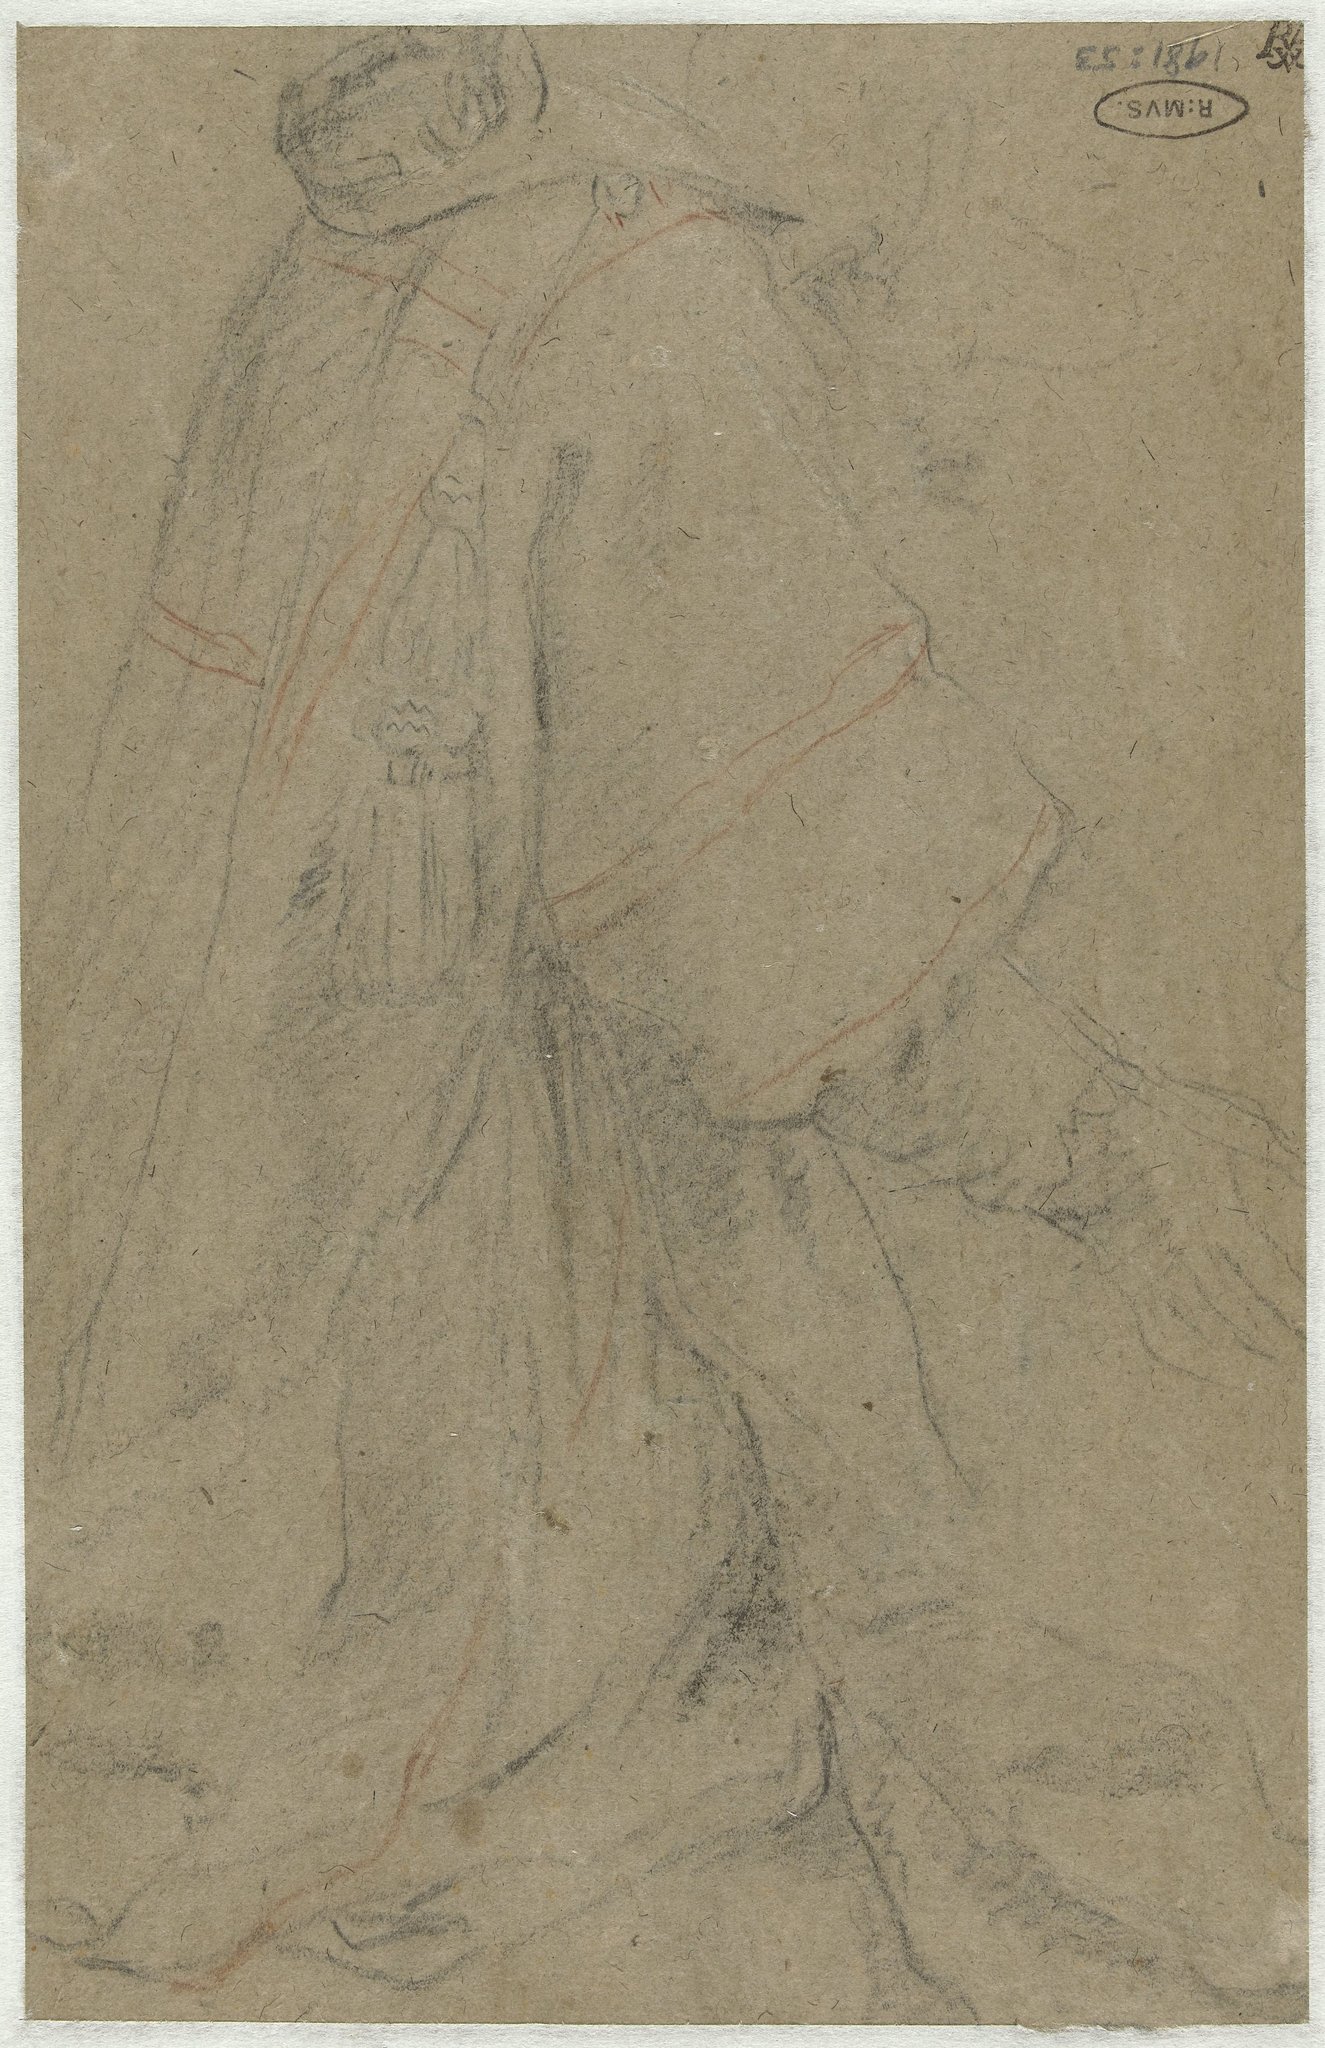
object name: drawing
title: Knielende geestelijke in dalmatiek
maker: domenichino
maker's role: draughtsman, painter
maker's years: 1581-1641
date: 1591-1641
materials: chalk, paper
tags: kneeling figure, organization, functionaries and dignitaries in roman catholic church; clergy in general